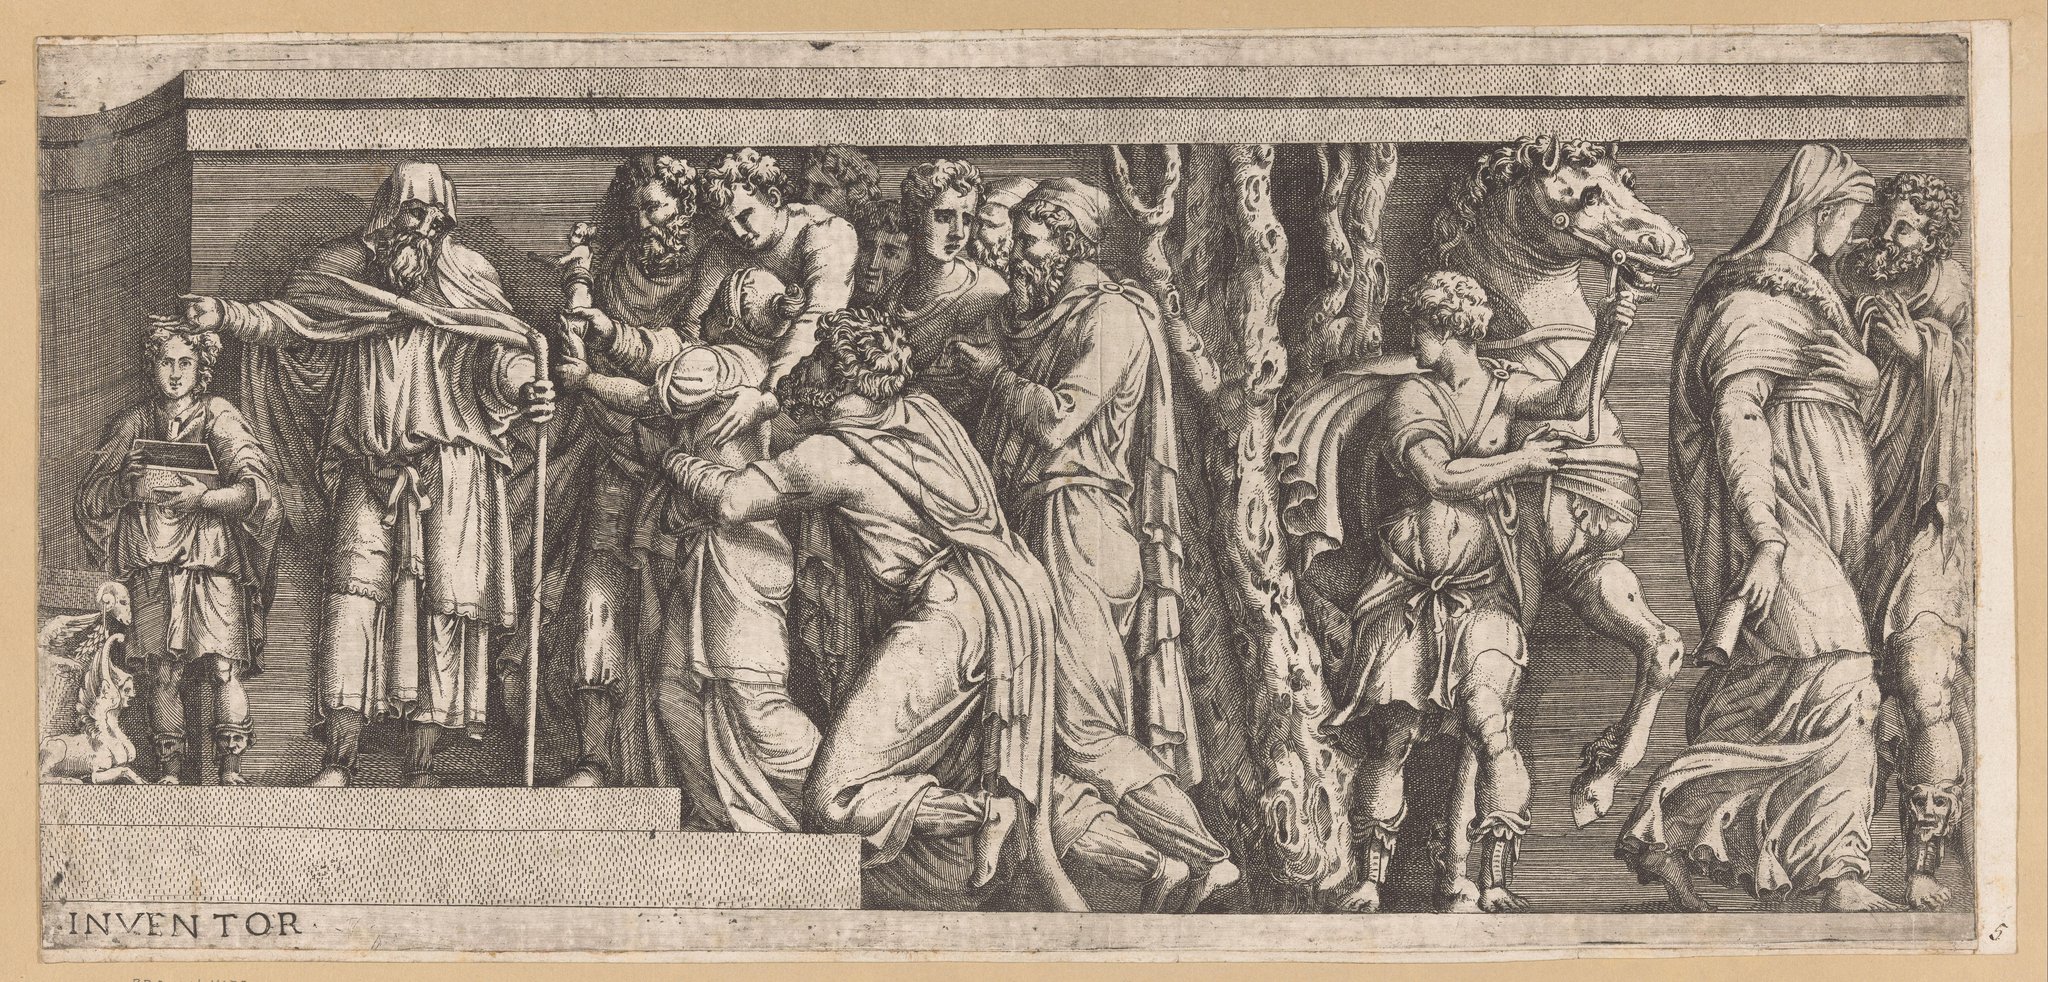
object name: print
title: Beeld van Niobe aanbeden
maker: Anonymous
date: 1500-1543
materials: paper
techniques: etching, intaglio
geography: italy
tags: bringing gifts; exchanging gifts, (story of) niobe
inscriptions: collector's mark: Lugt 10, number: ‘5’, collector's mark: ‘Hinloopen’, collector's mark: Lugt 11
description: Op een verhoging staat een priester die met zijn arm gebaart richting een altaar. Te midden van een menigte staat een jong meisje dat een kleine sculptuur aanbiedt. Rechts kijkt een jongeman met een paard toe.